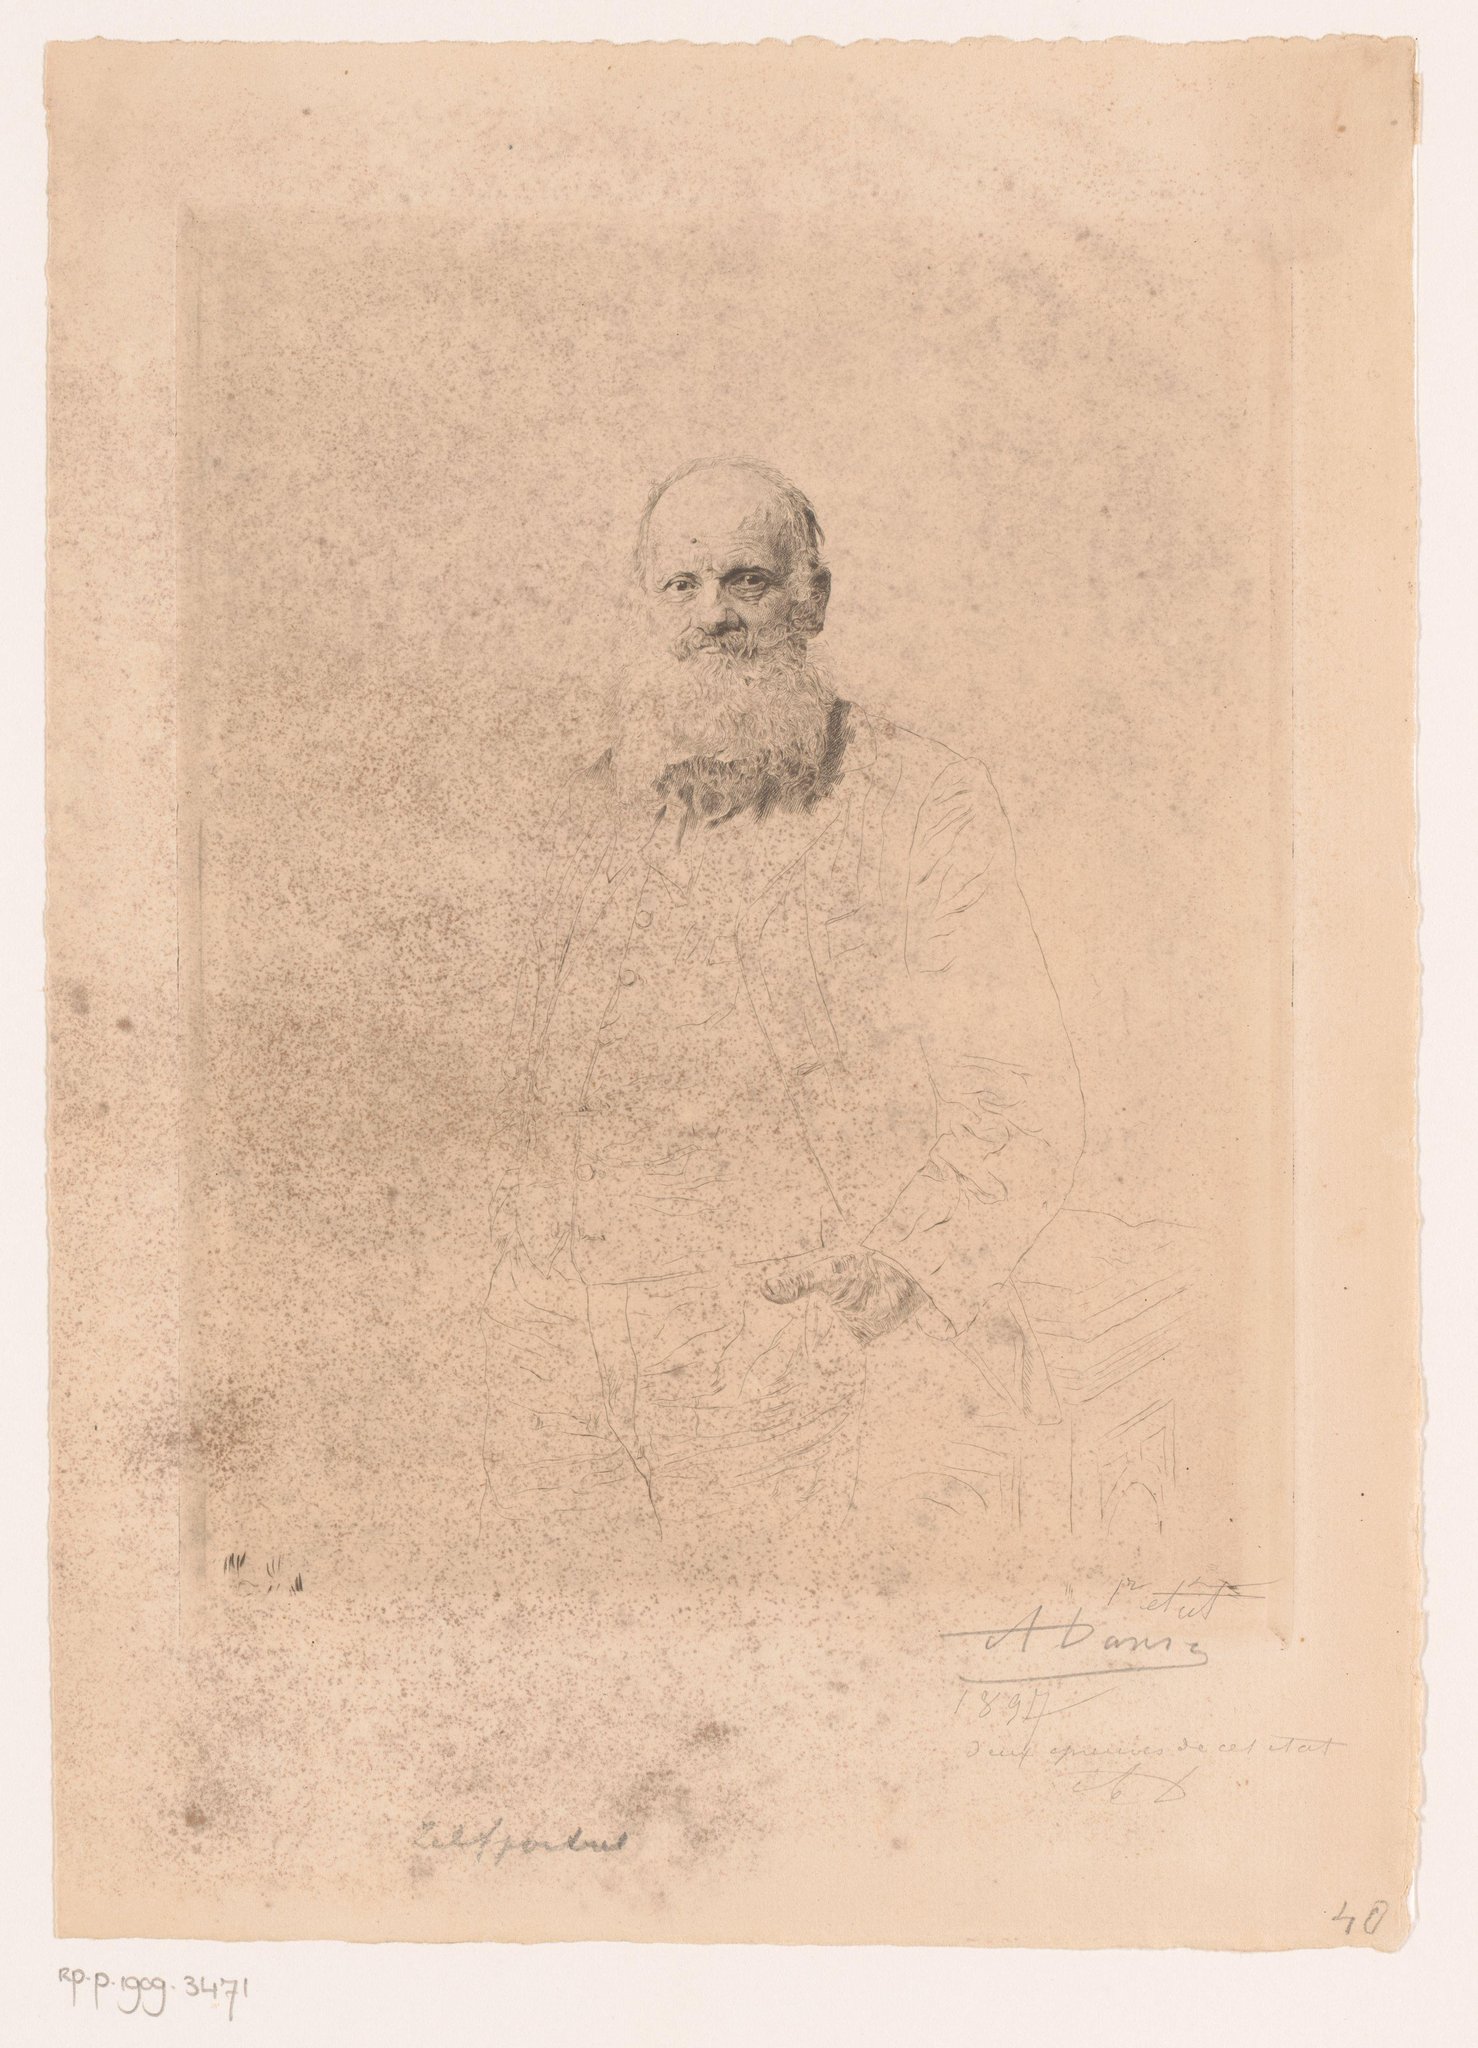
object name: print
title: Zelfportret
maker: auguste danse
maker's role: print maker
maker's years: 1829-1929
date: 1897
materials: paper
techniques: etching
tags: brussels, print maker, auguste danse, portrait, self-portrait of artist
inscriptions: collector's mark: Lugt 2228, annotation: ‘1er état; deux epreuves de cet etat’